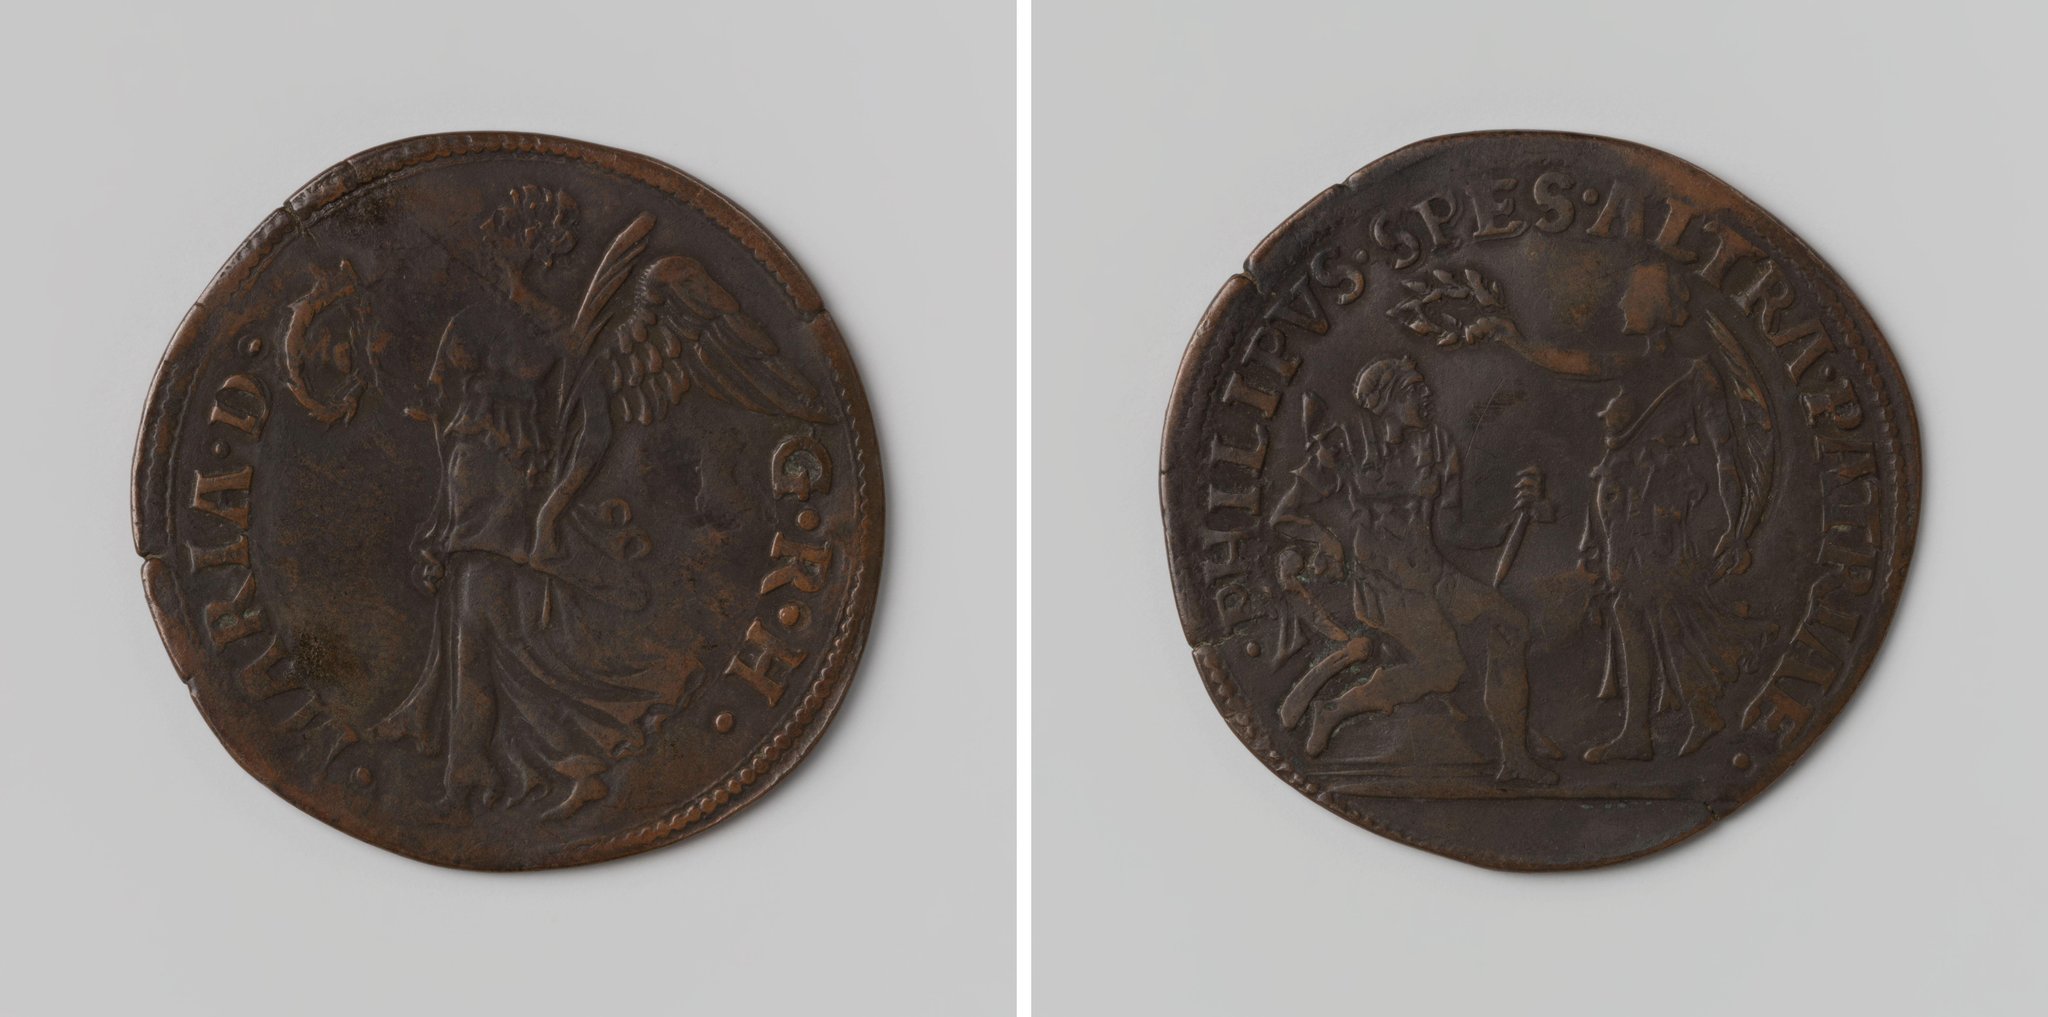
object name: jeton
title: Maria van Hongarije doet te Brussel afstand van de voogdij over de Nederlanden, ten gunst van Filips, erfprins van Spanje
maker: Anonymous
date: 1555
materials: copper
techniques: striking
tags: philip ii of spain, brussels, maria van hongarije (landvoogdes der nederlanden)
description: Koperen penning. Voorzijde: gevleugelde Overwinning met lauwerkrans in rechter- en palmtak in linkerhand binnen omschrift. Keerzijde: staande vrouw, voorstellende Overwinning, houdt palmtak in linkerhand en houdt met uitgestrekte rechterhand een lauwerkrans boven hoofd van Filips, die in Romeins tenue gekleed, op stoel zit met commandostaf in hand binnen omschrift